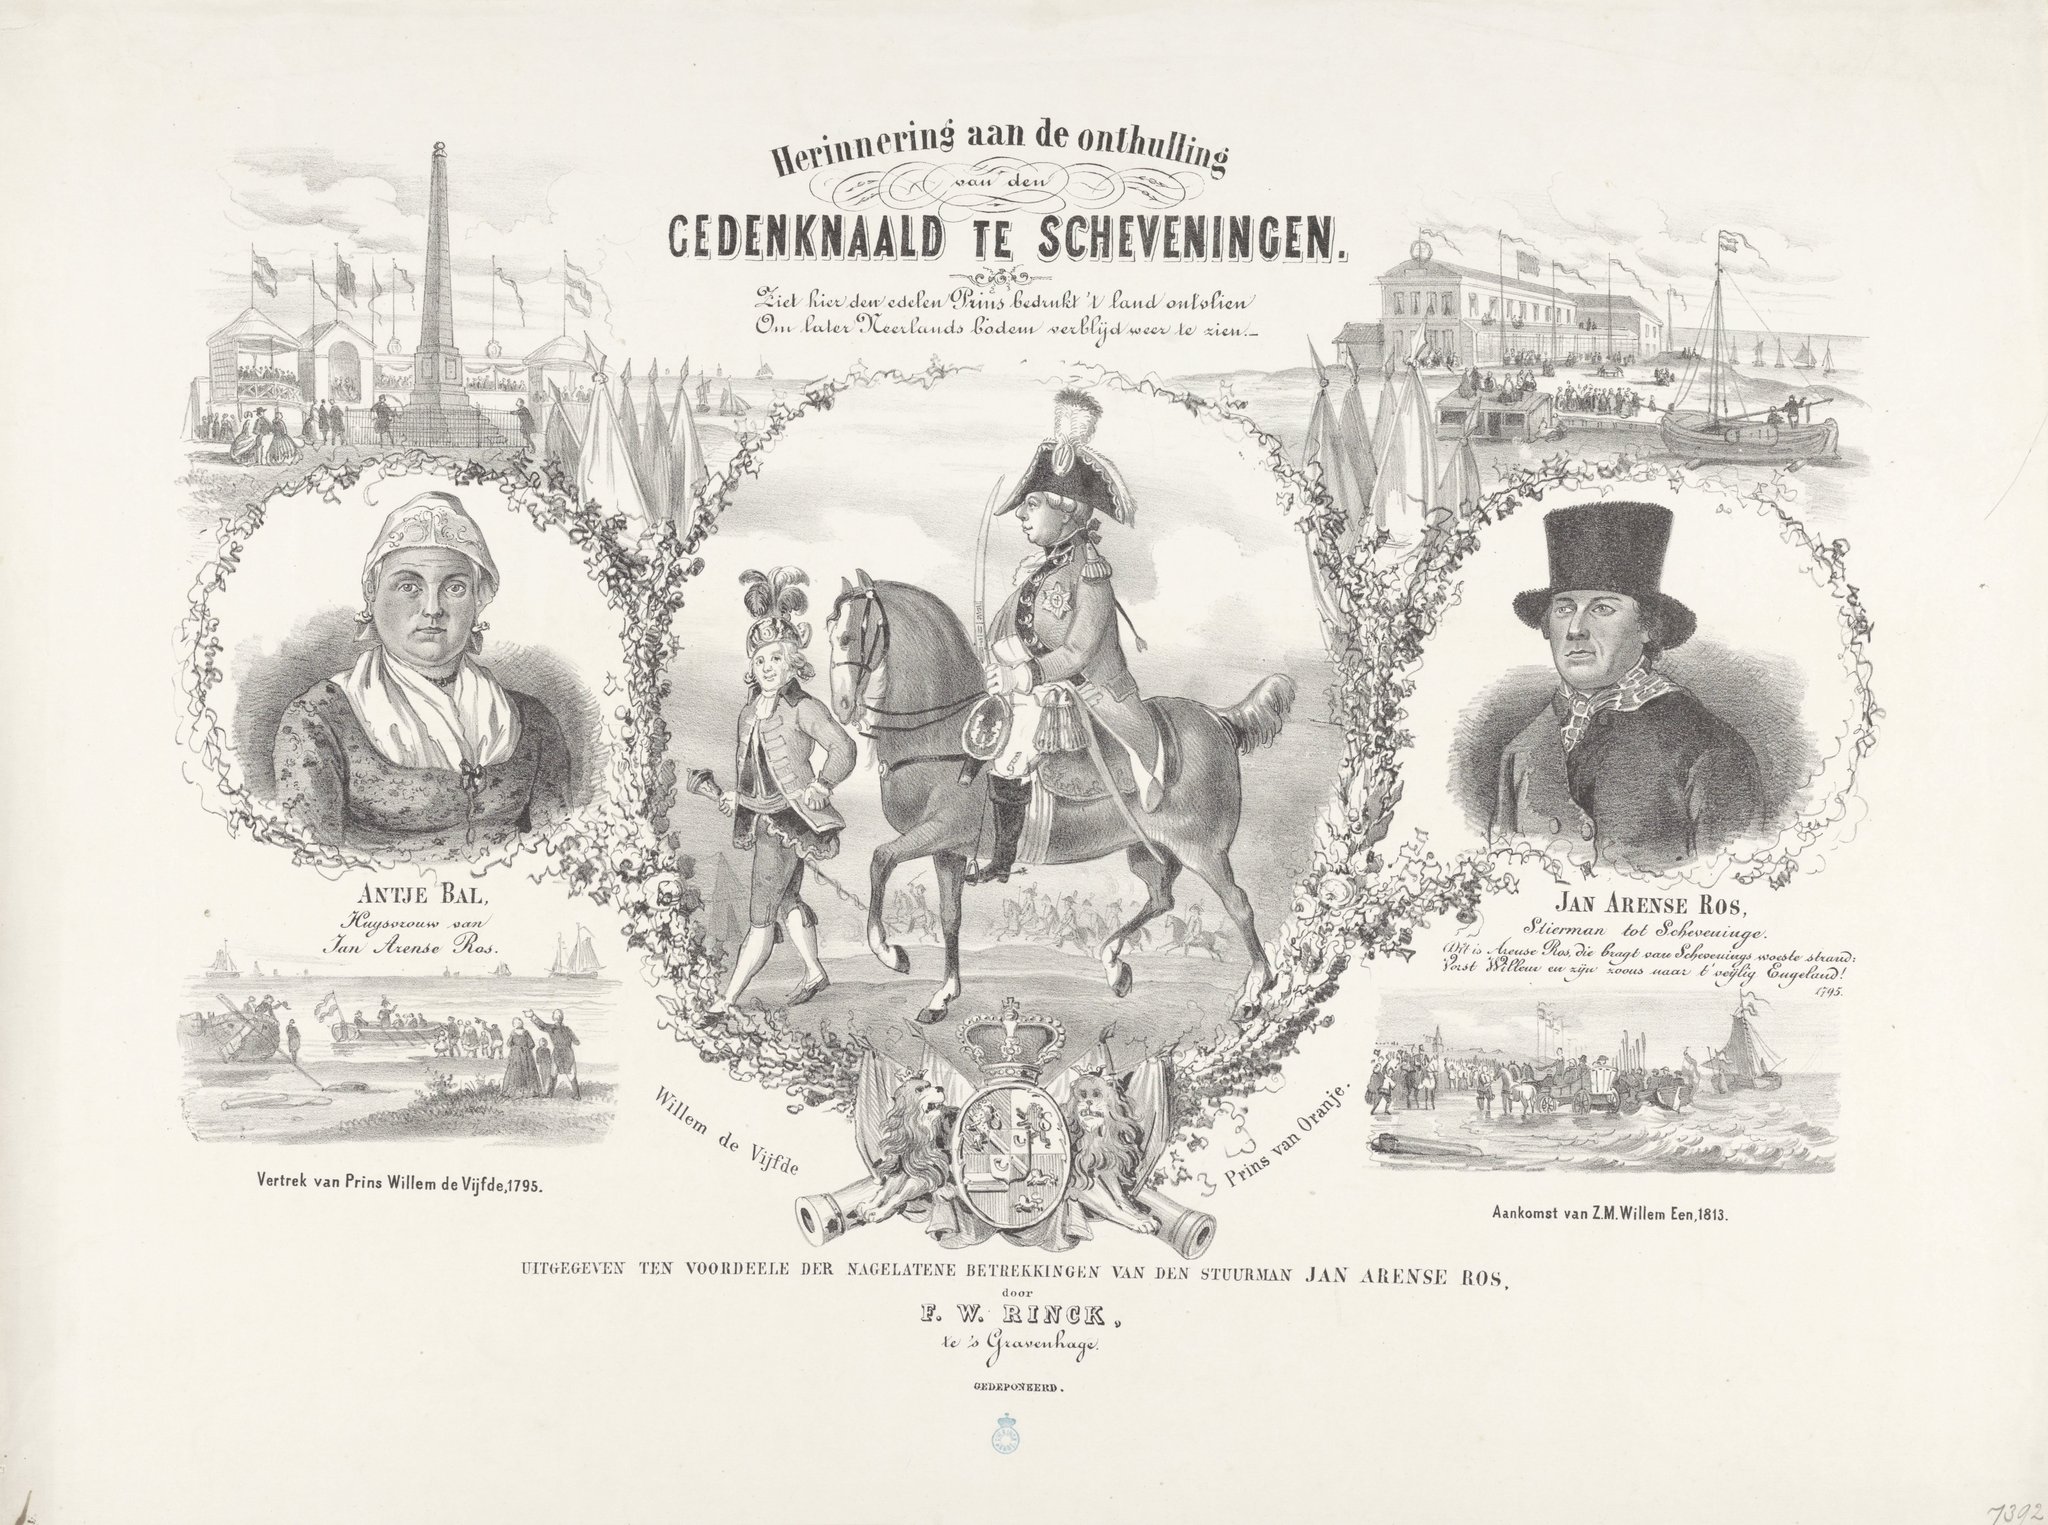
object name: print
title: Herinnering aan de onthulling van de gedenknaald te Scheveningen op de plaats waar Willem V in 1795 naar Engeland is vertrokken, 1865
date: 1865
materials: paper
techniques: lithograph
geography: the hague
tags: the hague, william v (prince of orange), berlin, william i of the netherlands, monument, statue, departure ~ travelling, landing of william frederick i (1813)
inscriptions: company name: ‘stempel van de uitgever; gekroond rondje waarin de naam 'F.W. Rinck 's Hage.'’, collector's mark: Lugt 2228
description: Gedenkprent uitgegeven bij de onthulling van de gedenknaald te Scheveningen op de plaats waar vandaan stadhouder Willem V naar Engeland is vertrokken op 18 januari 1795 en koning Willem I in 1813 is teruggekeerd. Monument onthuld op 24 augustus 1865. Centraal de prins Willem V te paard, rechts de stuurman Jan Arense Ros die de prins en zijn zoons naar Engeland bracht, rechts zijn echtgenote Antje Bal. Linksboven de gedenknaald, rechtsboven het Badhuis van Maas ofwel hotel Zeerust. Linksonder het vertrek van Willem V, rechtsonder de aankomst van koning Willem I in 1813.